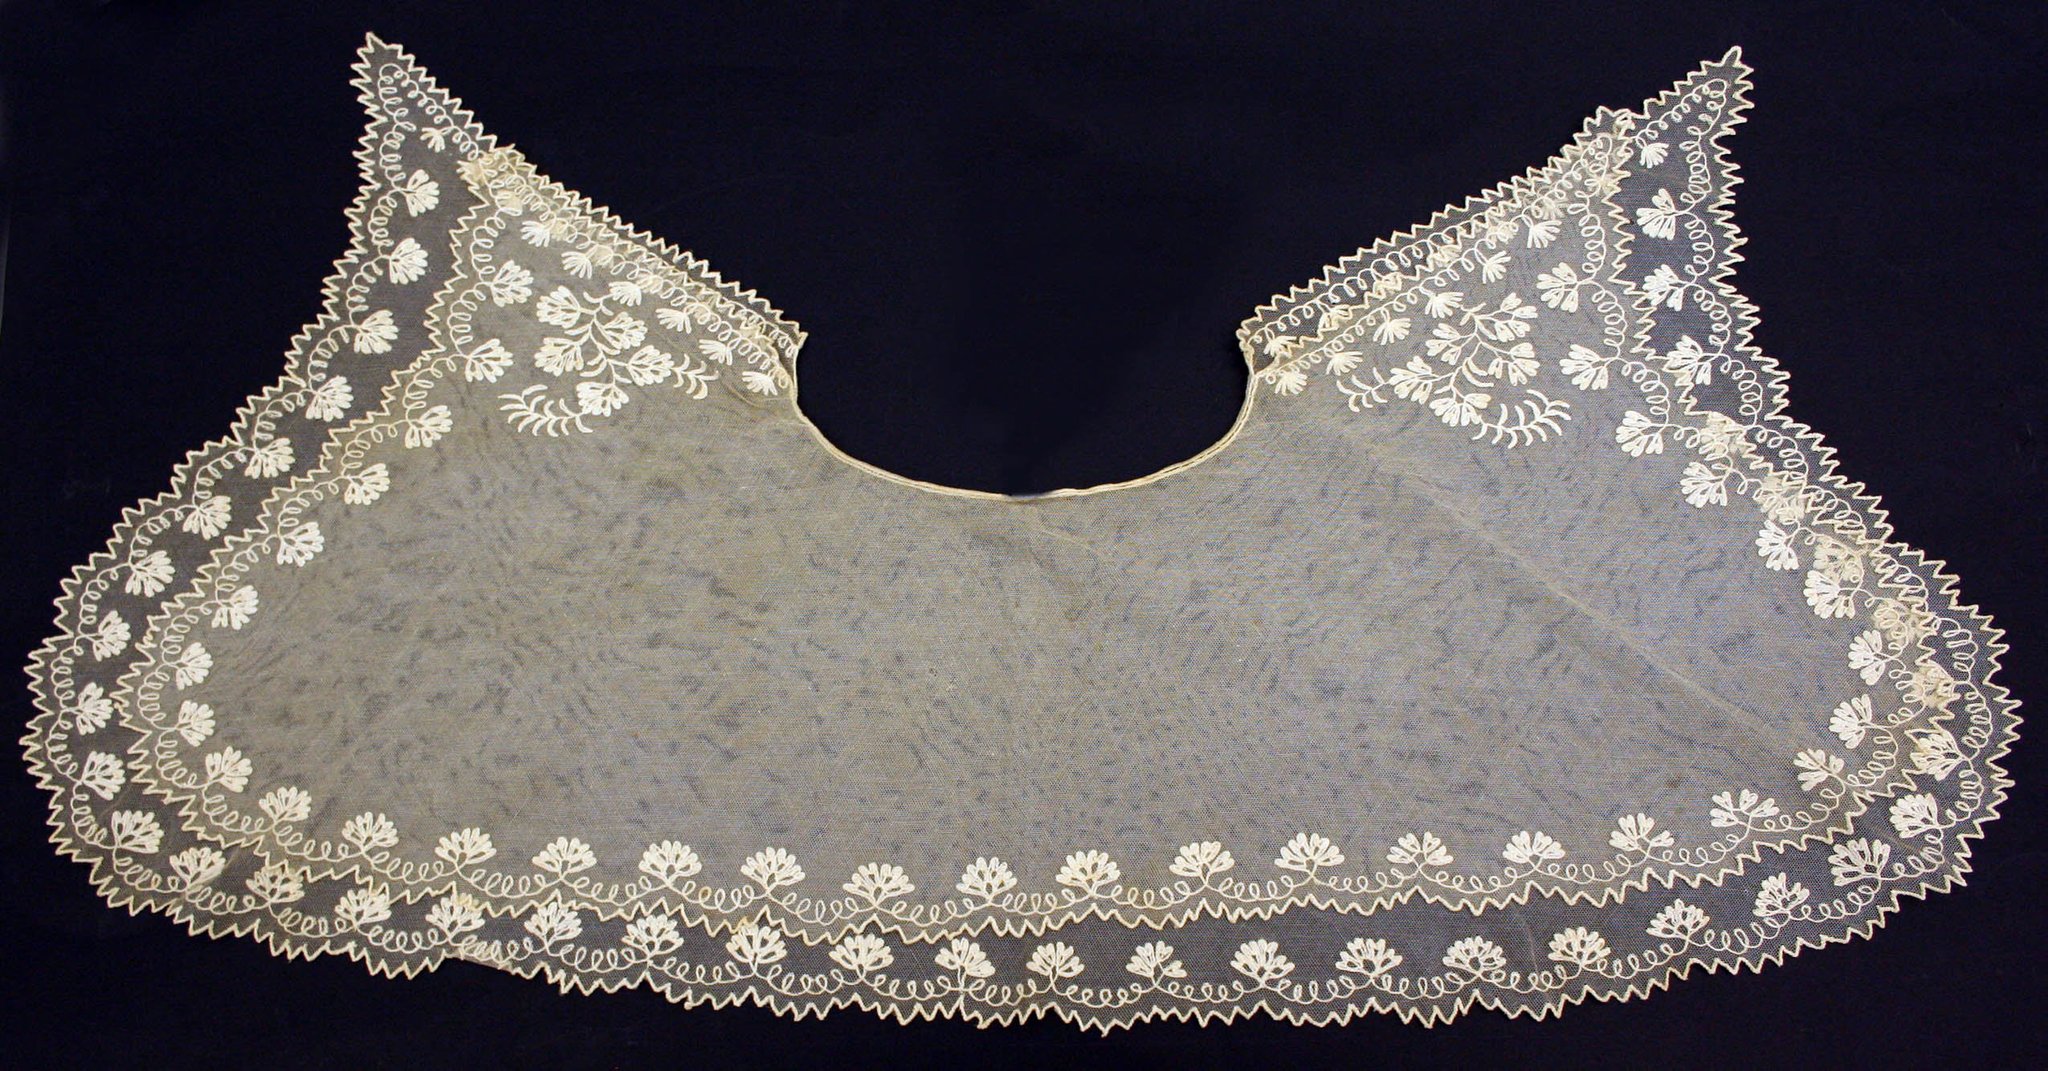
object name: pelerine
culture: american or european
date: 1825-1835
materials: cotton